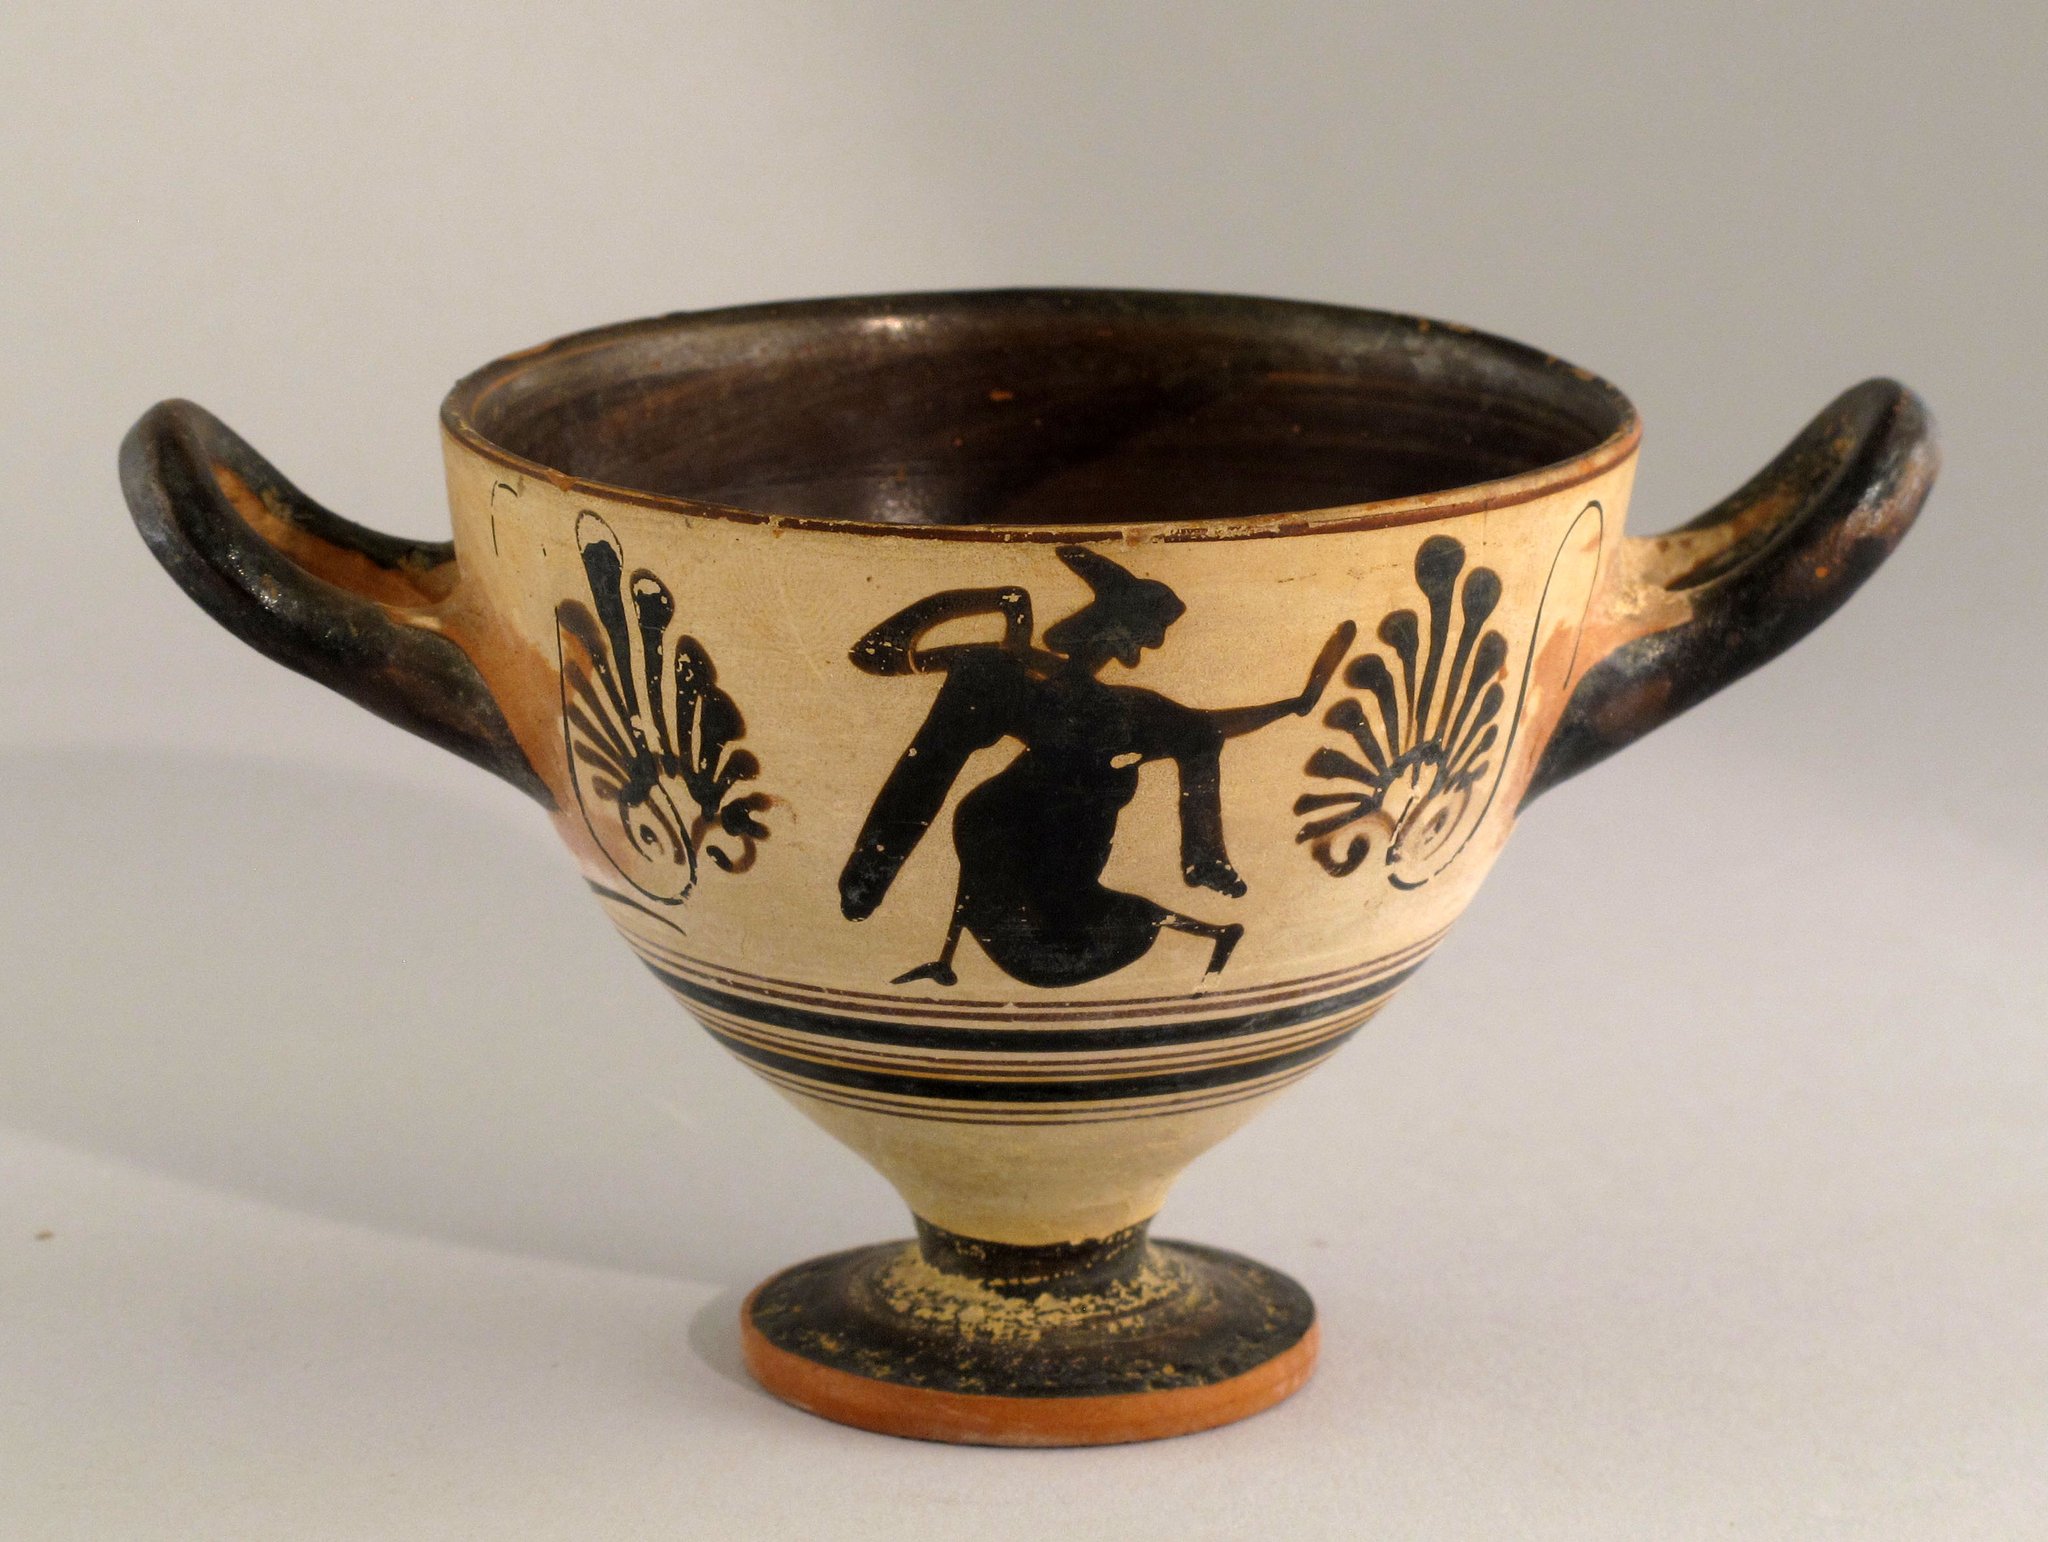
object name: skyphos, pistian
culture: greek, attic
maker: haimon painter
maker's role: artist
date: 500-476 BCE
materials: terracotta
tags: women,dancing